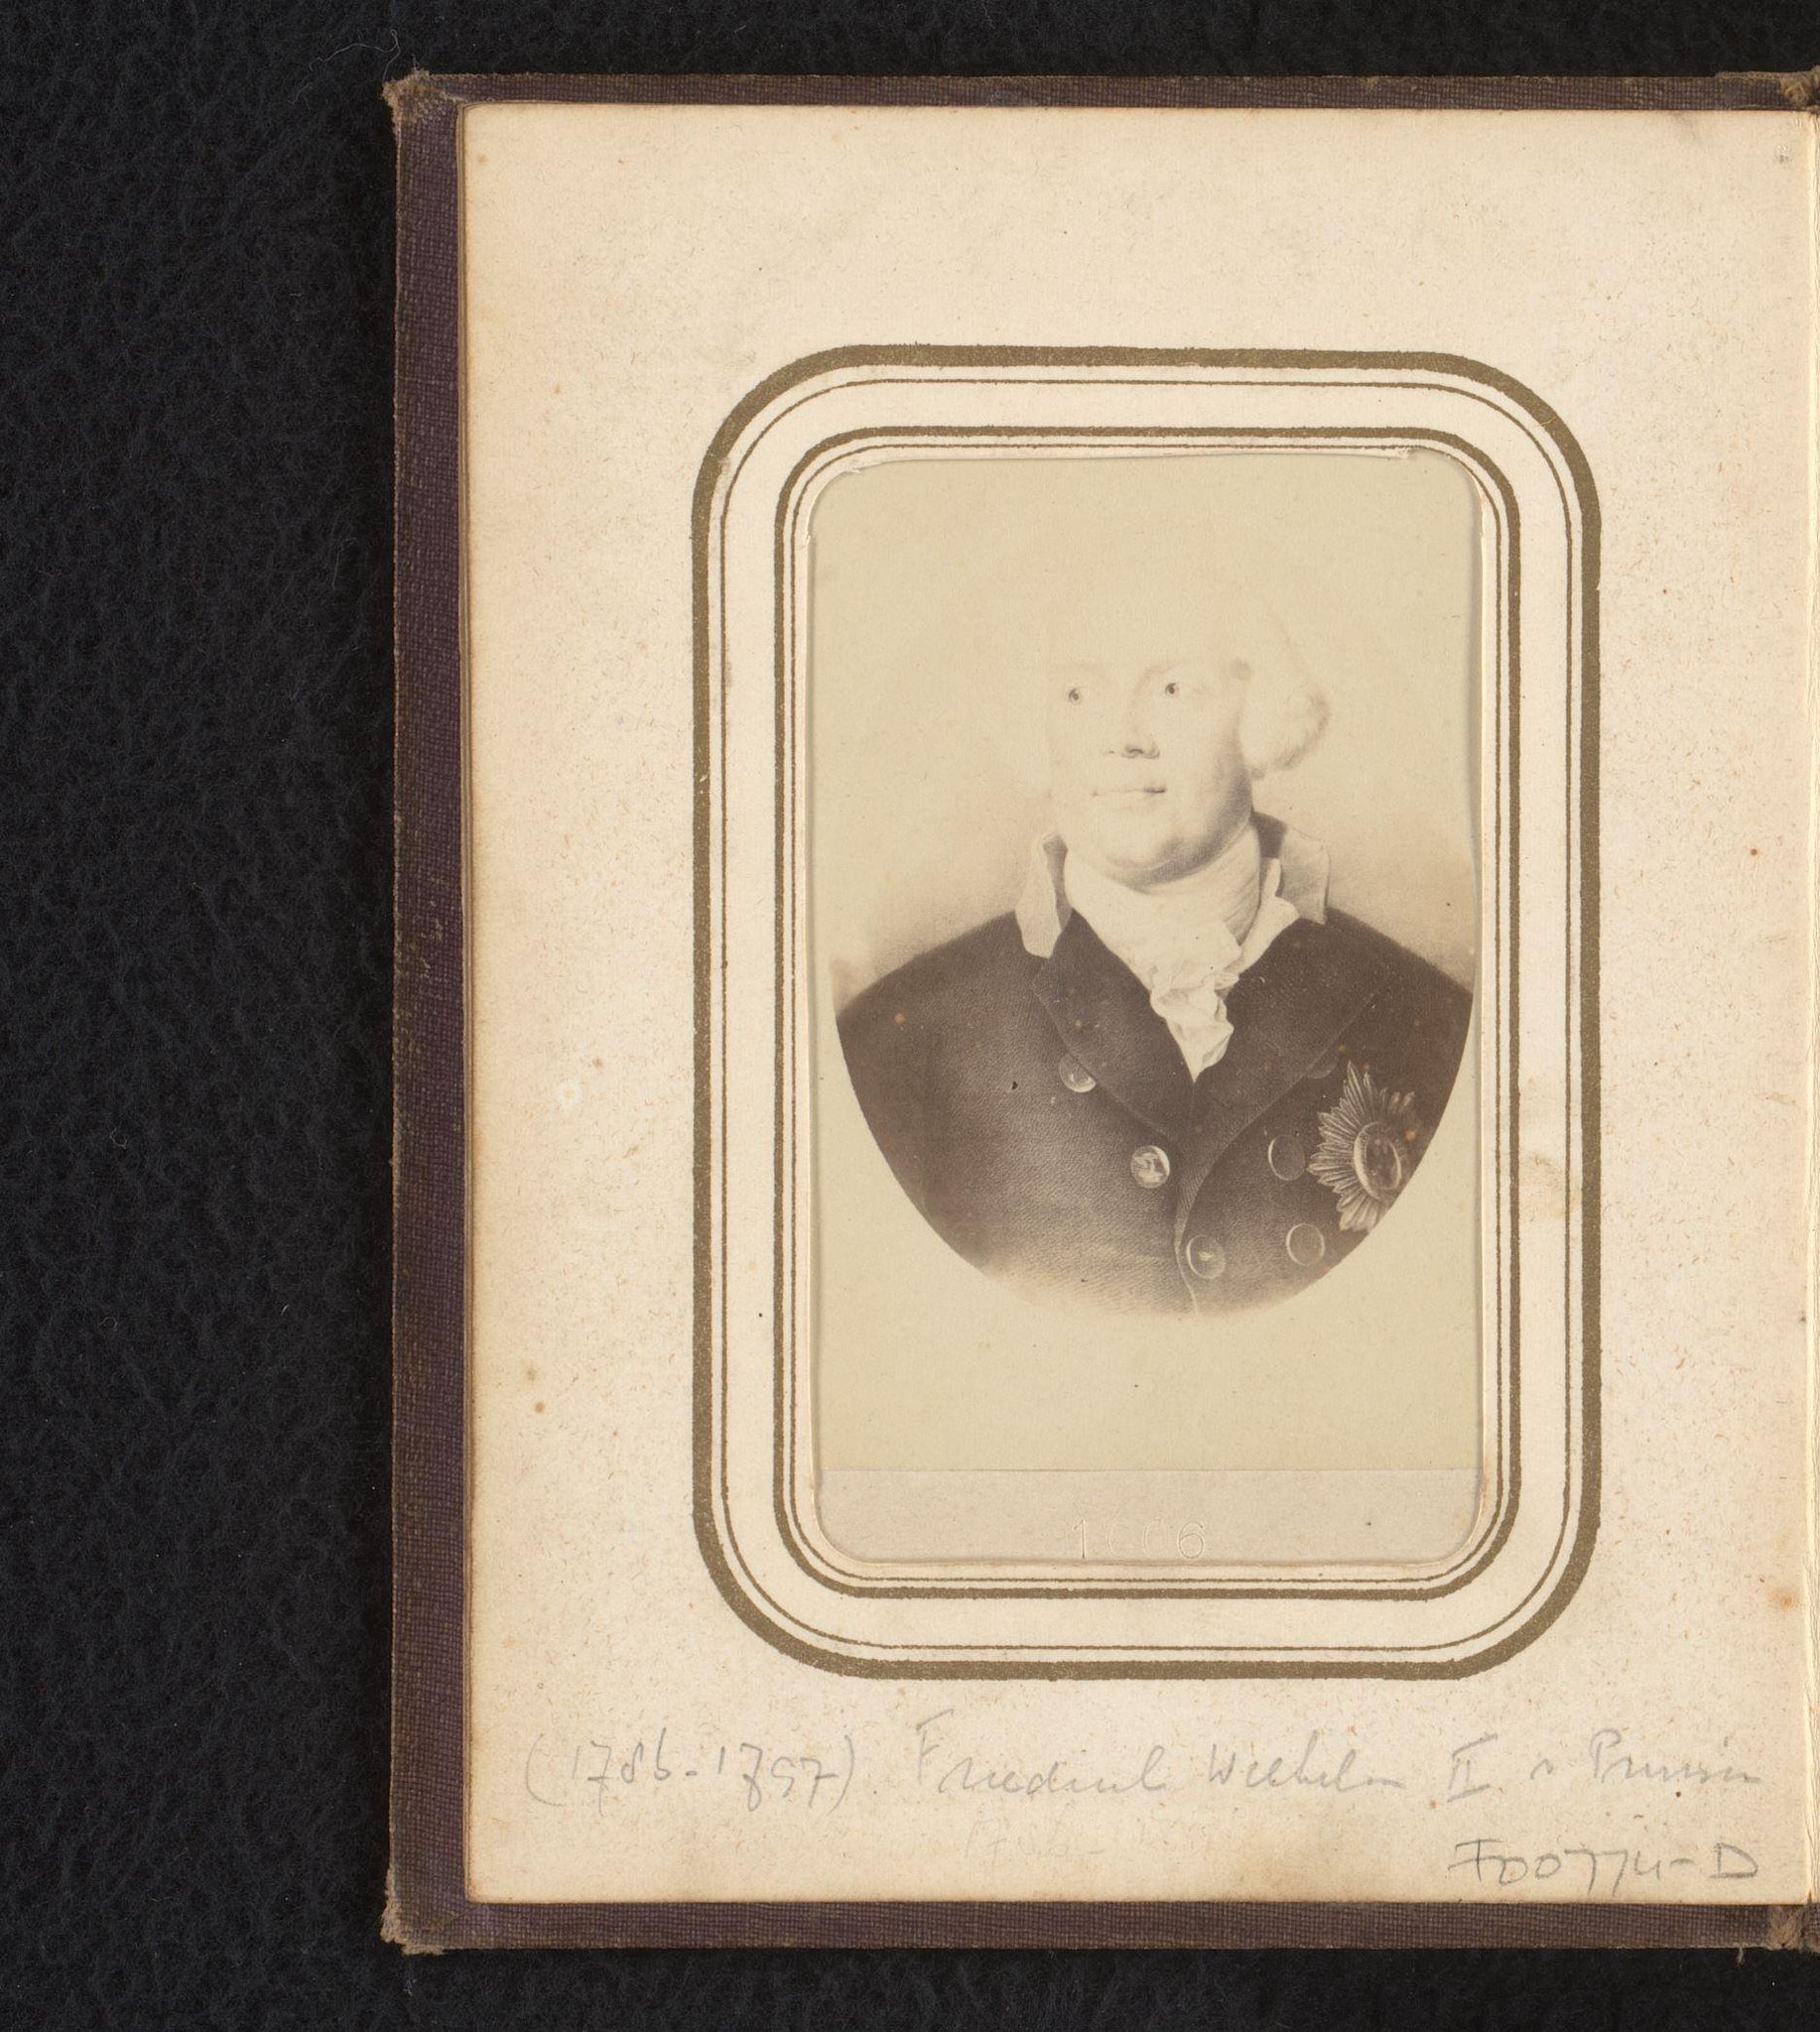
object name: carte de visite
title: Fotoreproductie van een prent van een portret van koning Frederik Willem II van Pruisen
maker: Anonymous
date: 1850-1900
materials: cardboard, photographic support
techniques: albumen print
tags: berlin, frederik willem ii (koning van pruisen), historical persons, king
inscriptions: annotation: ‘(1786-1797) Friedrich Wilhelm II v Pruissen’, inscription: ‘1006./ Fréderic Guillaume II., roi de Prusse/ Friedr. Wilhelm II., König v. Preussen./ Frederic William II., king of Prussia.’, number: ‘1006’